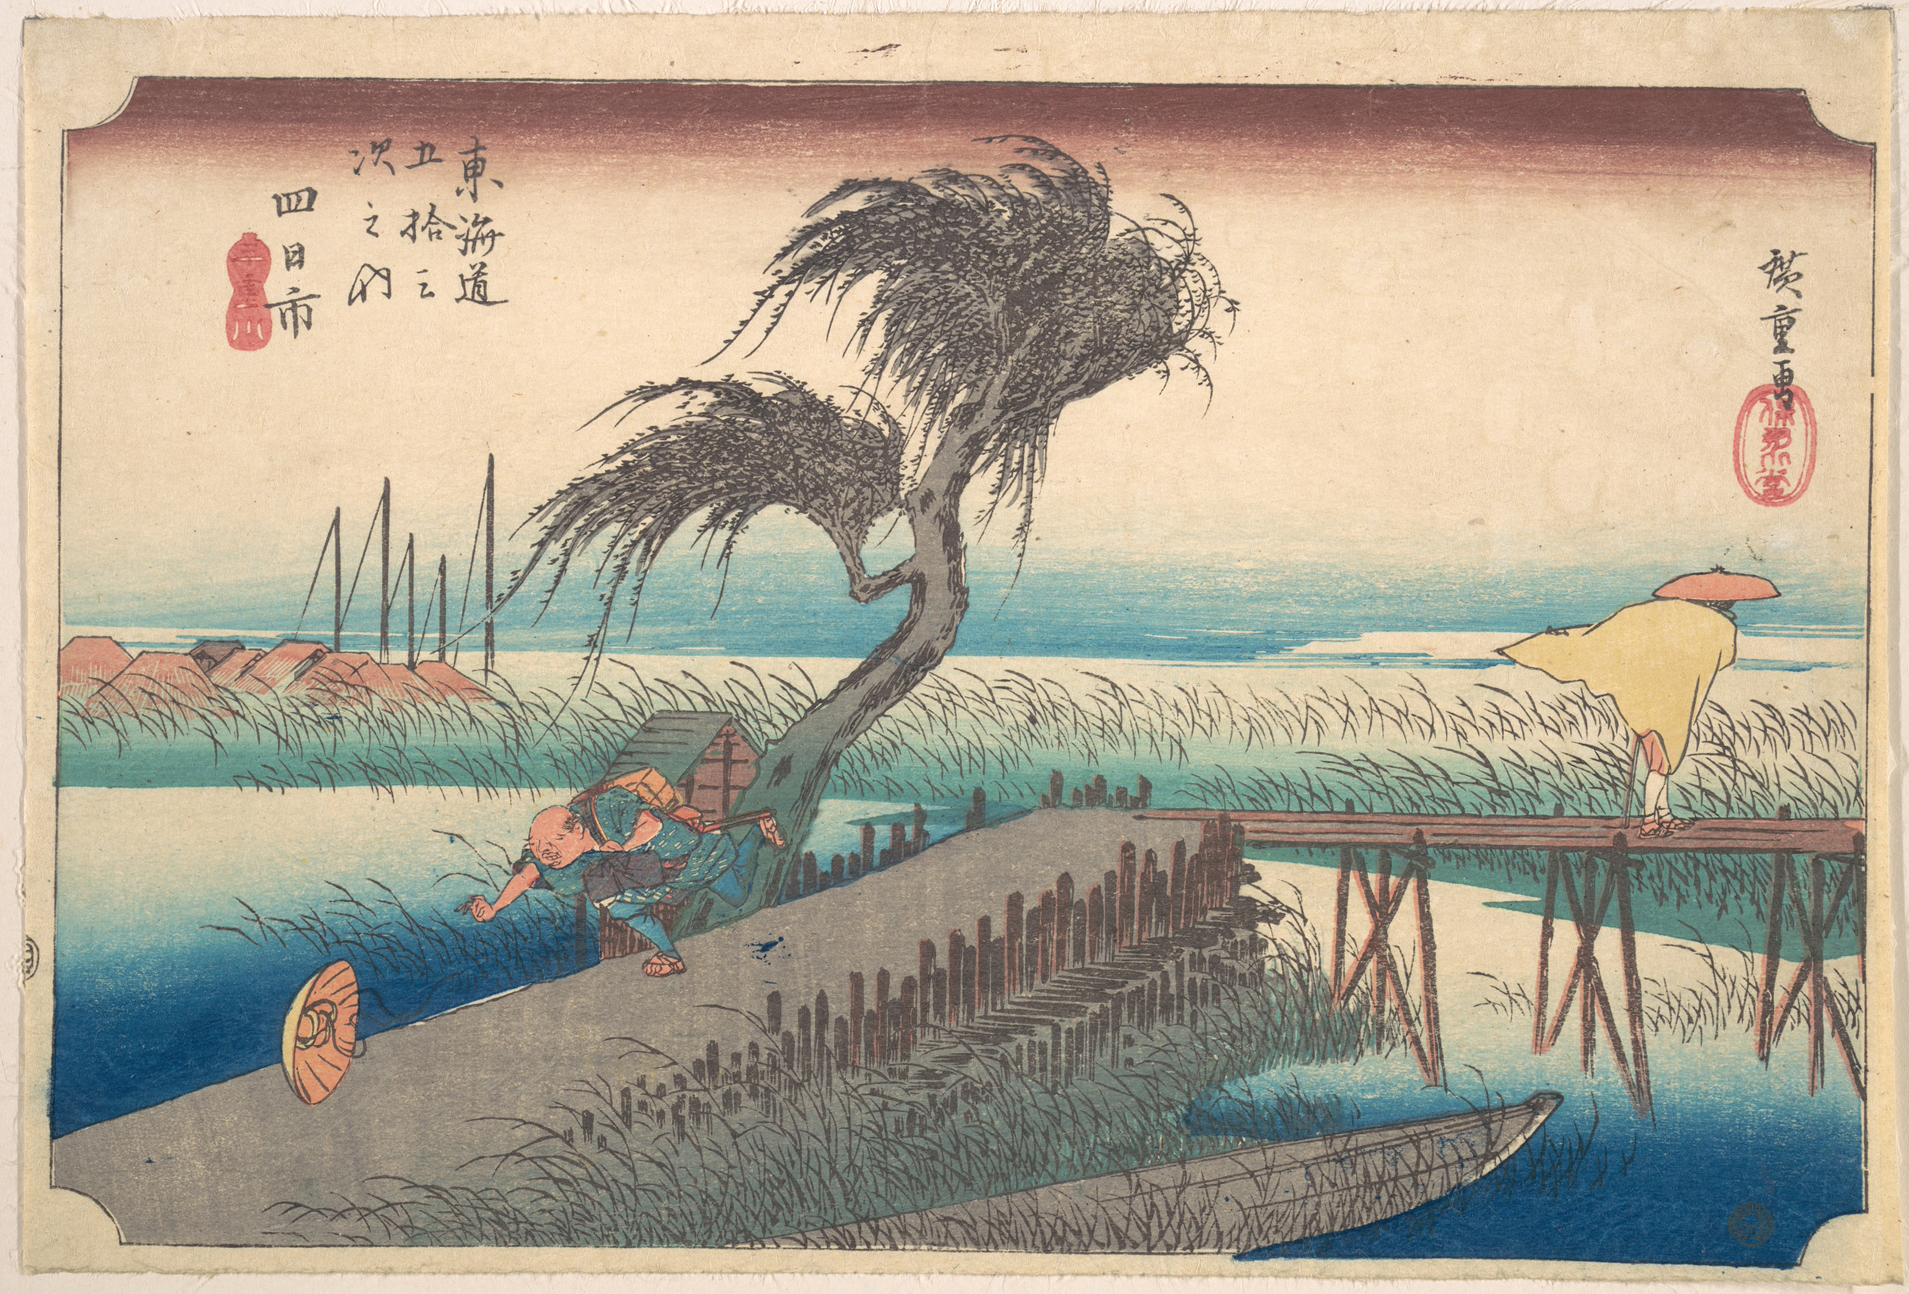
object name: print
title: Yokkaichi, Sanchokawa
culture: japanese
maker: utagawa hiroshige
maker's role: artist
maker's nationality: japanese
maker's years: 1797-1858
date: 1834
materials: ink, paper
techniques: woodblock print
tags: men,trees,storms